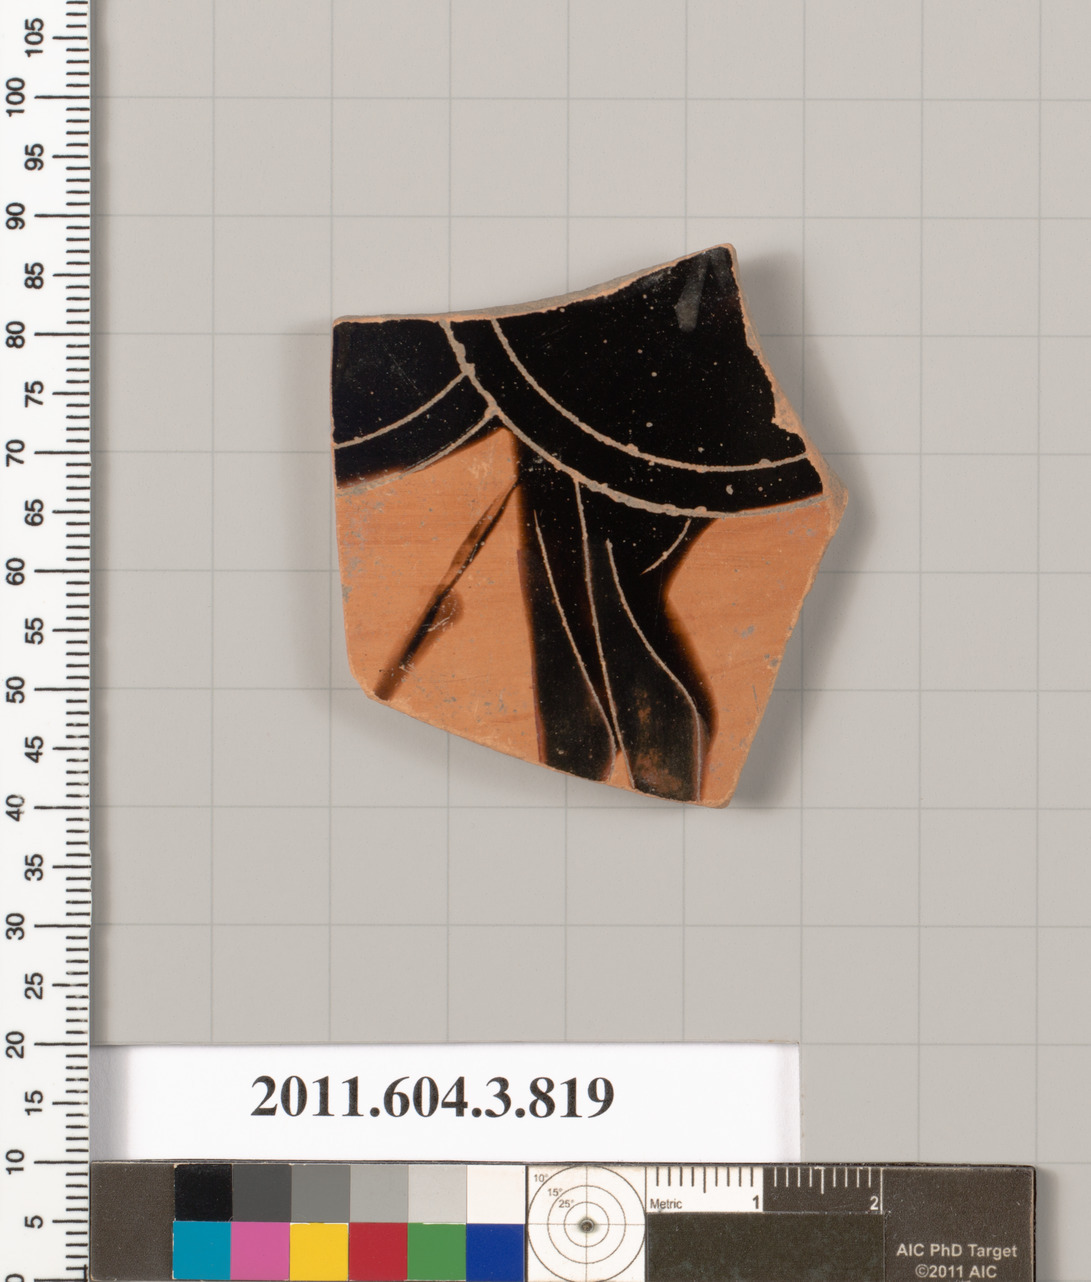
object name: lekythos fragment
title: Terracotta fragment of a lekythos (oil flask)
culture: greek, attic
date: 534-501 BCE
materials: terracotta